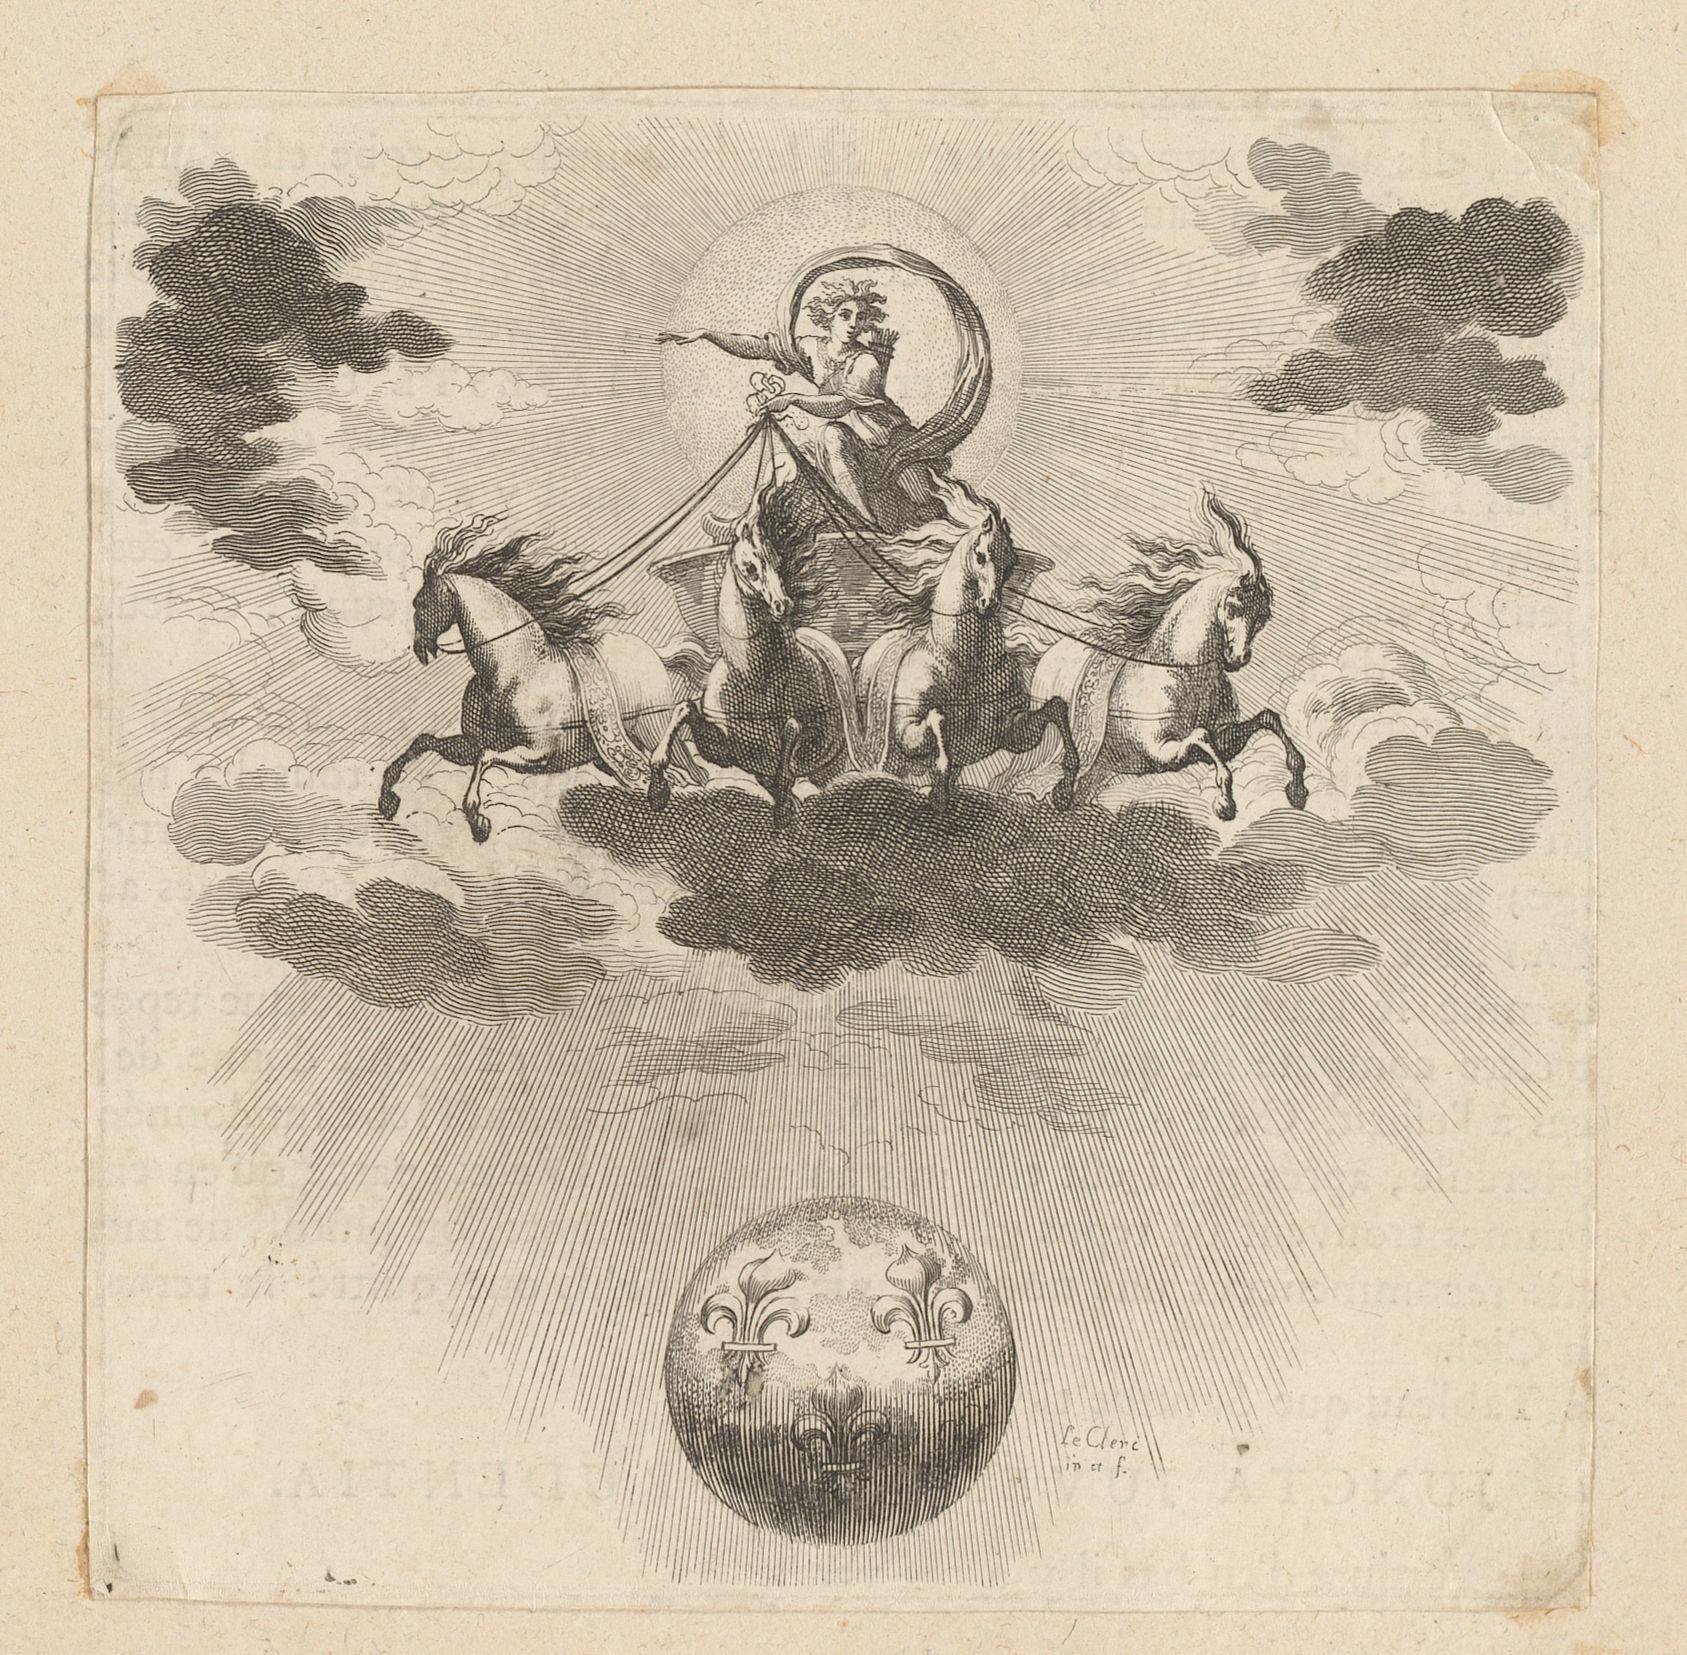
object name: album leaf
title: Aurora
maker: sébastien leclerc (i)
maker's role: print maker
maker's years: 1637-1714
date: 1647-1714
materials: paper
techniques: engraving, etching, letterpress printing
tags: triumph of aurora: in her chariot drawn by two (sometimes four) horses, and possibly scattering flowers; aurora's victory over the night; 'carro dell'aurora' (ripa)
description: Prent gebruikt in een onbekende publicatie.